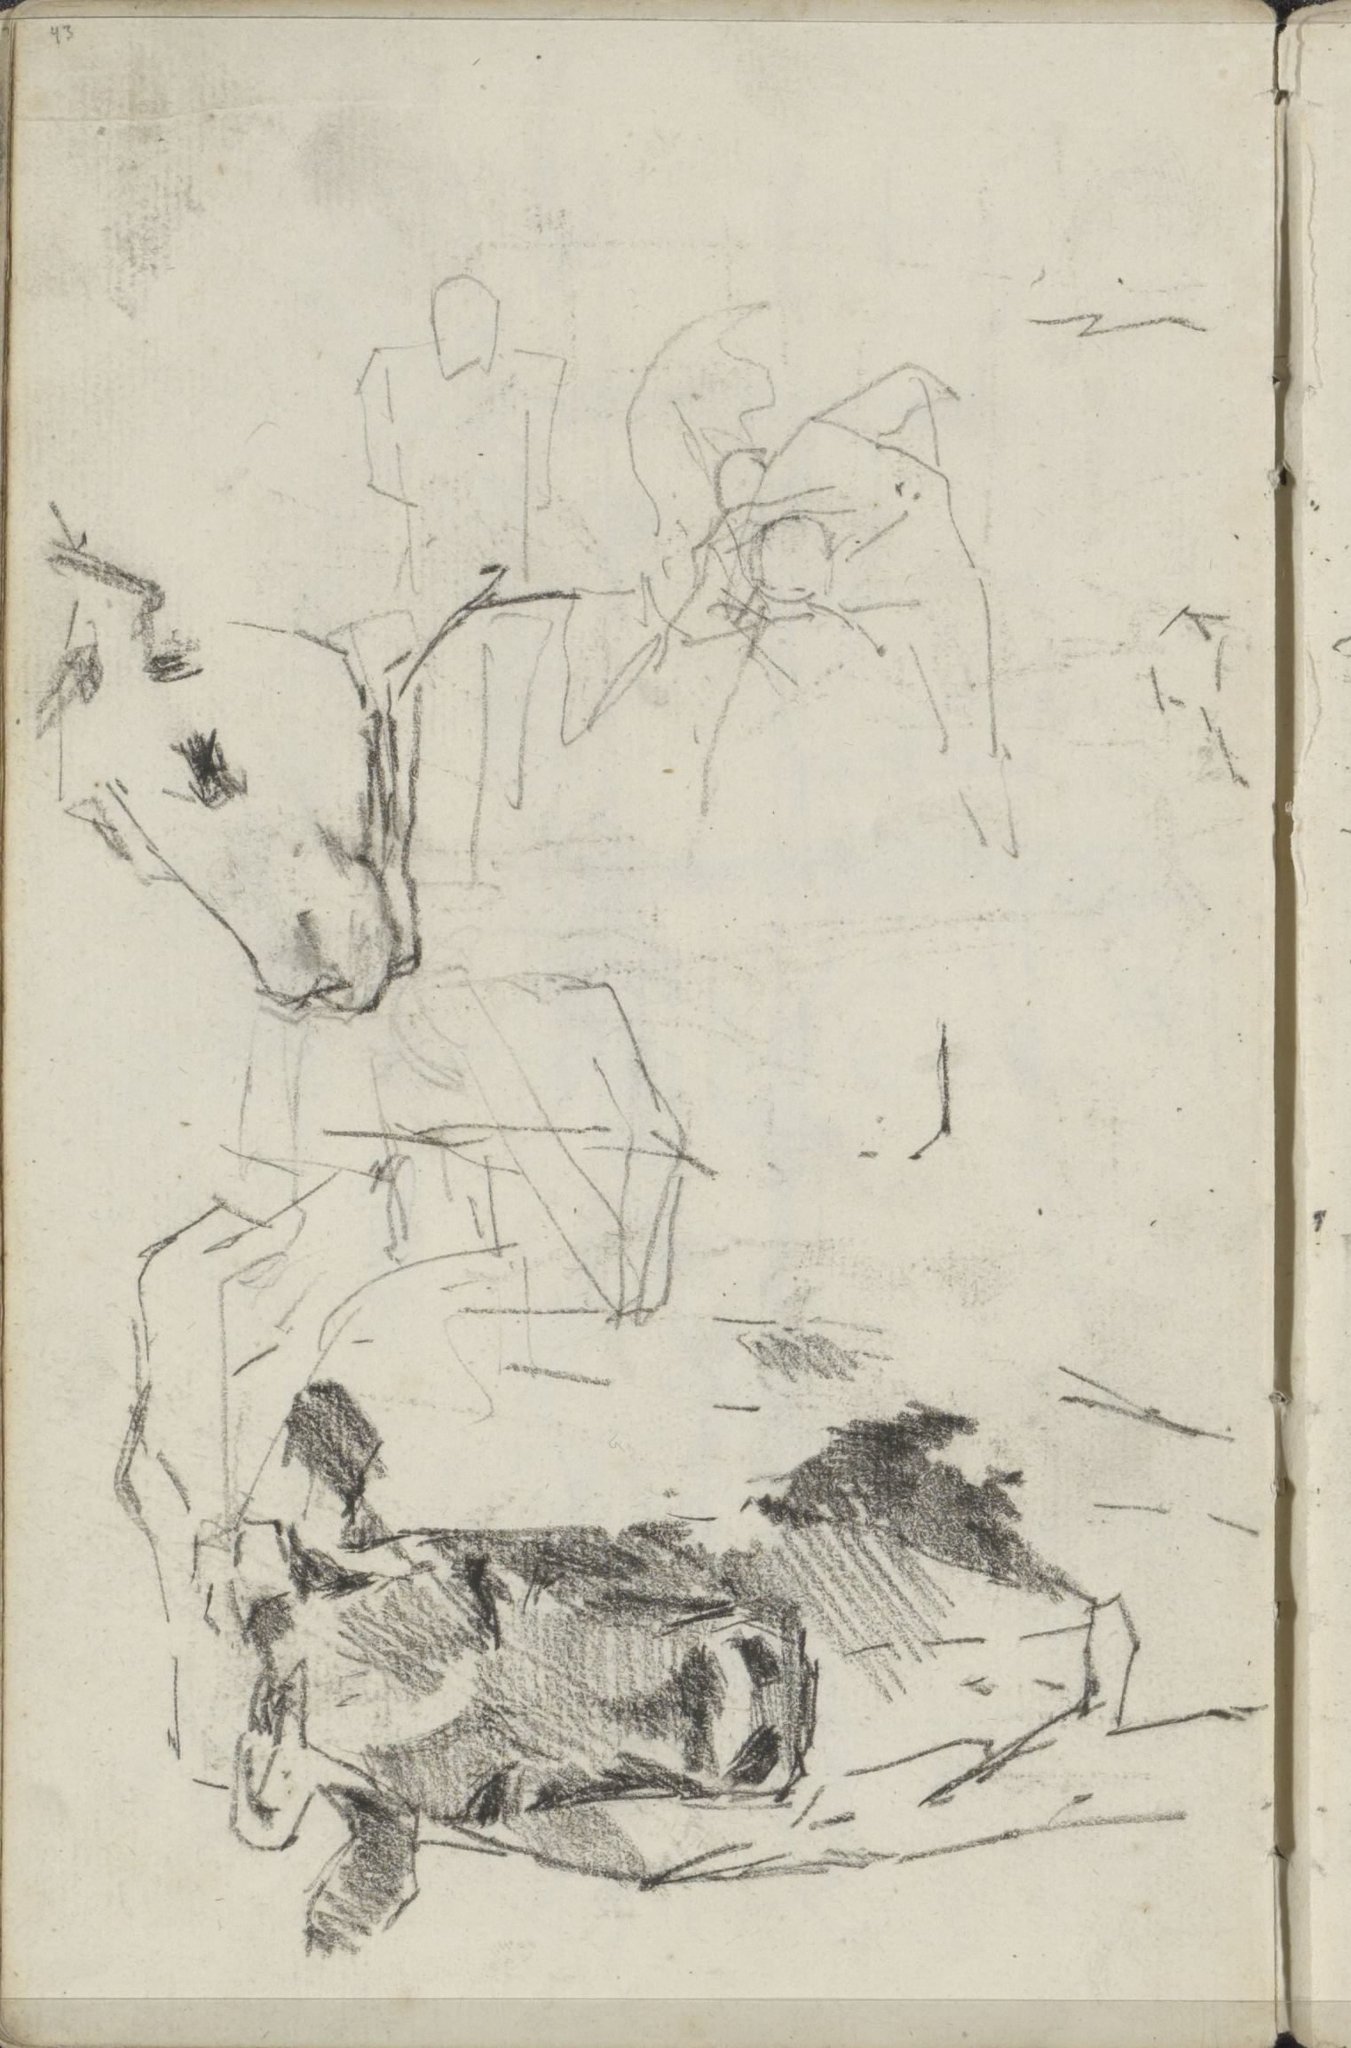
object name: sketchbook leaf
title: Koeien en figuren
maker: george hendrik breitner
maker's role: draughtsman, painter, print maker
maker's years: 1857-1923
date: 1880-1882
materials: chalk, paper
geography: the hague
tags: cow, adult man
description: Pagina 43 uit een schetsboek met 23 bladen.